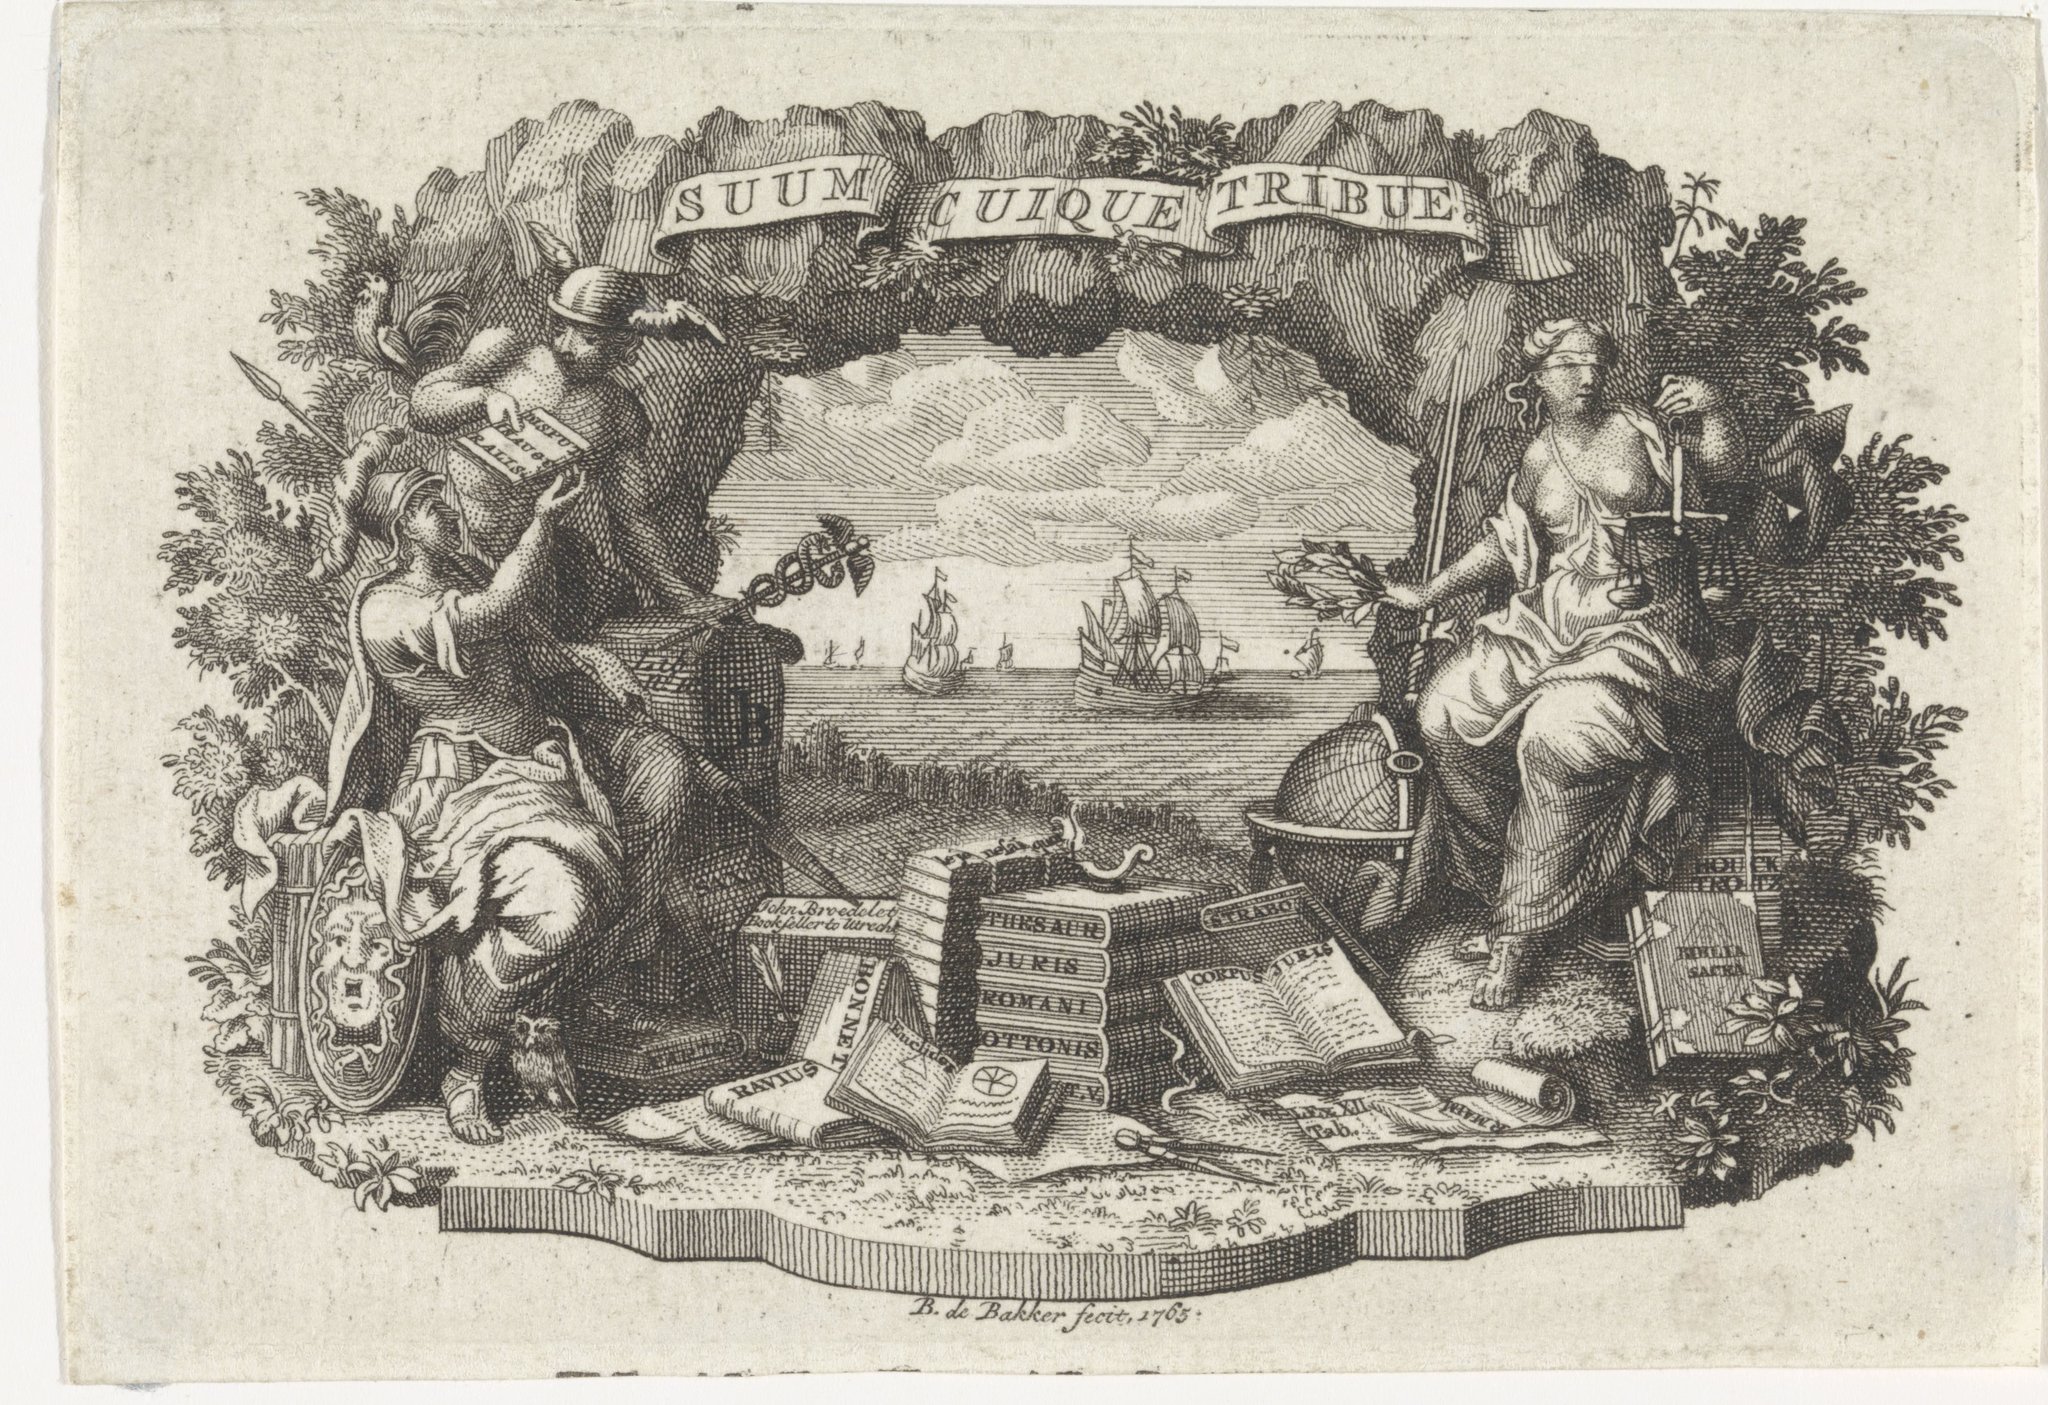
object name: print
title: Suum cuique tribue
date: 1765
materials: paper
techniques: engraving, etching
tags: justice, 'justitia'; 'giustitia divina' (ripa) ~ one of the four cardinal virtues, (story of) mars (ares), (story of) mercury (hermes)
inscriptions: collector's mark: Lugt 2228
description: Allegorie op gerechtigheid met stapels wetboeken geflankeerd door Justitia, Mars en Mercurius en doorkijk naar zeelandschap met zeilschepen. De tekstband verwijst naar gerechtigheid met de uitspraak Iedereen krijgt wat hem toekomt.